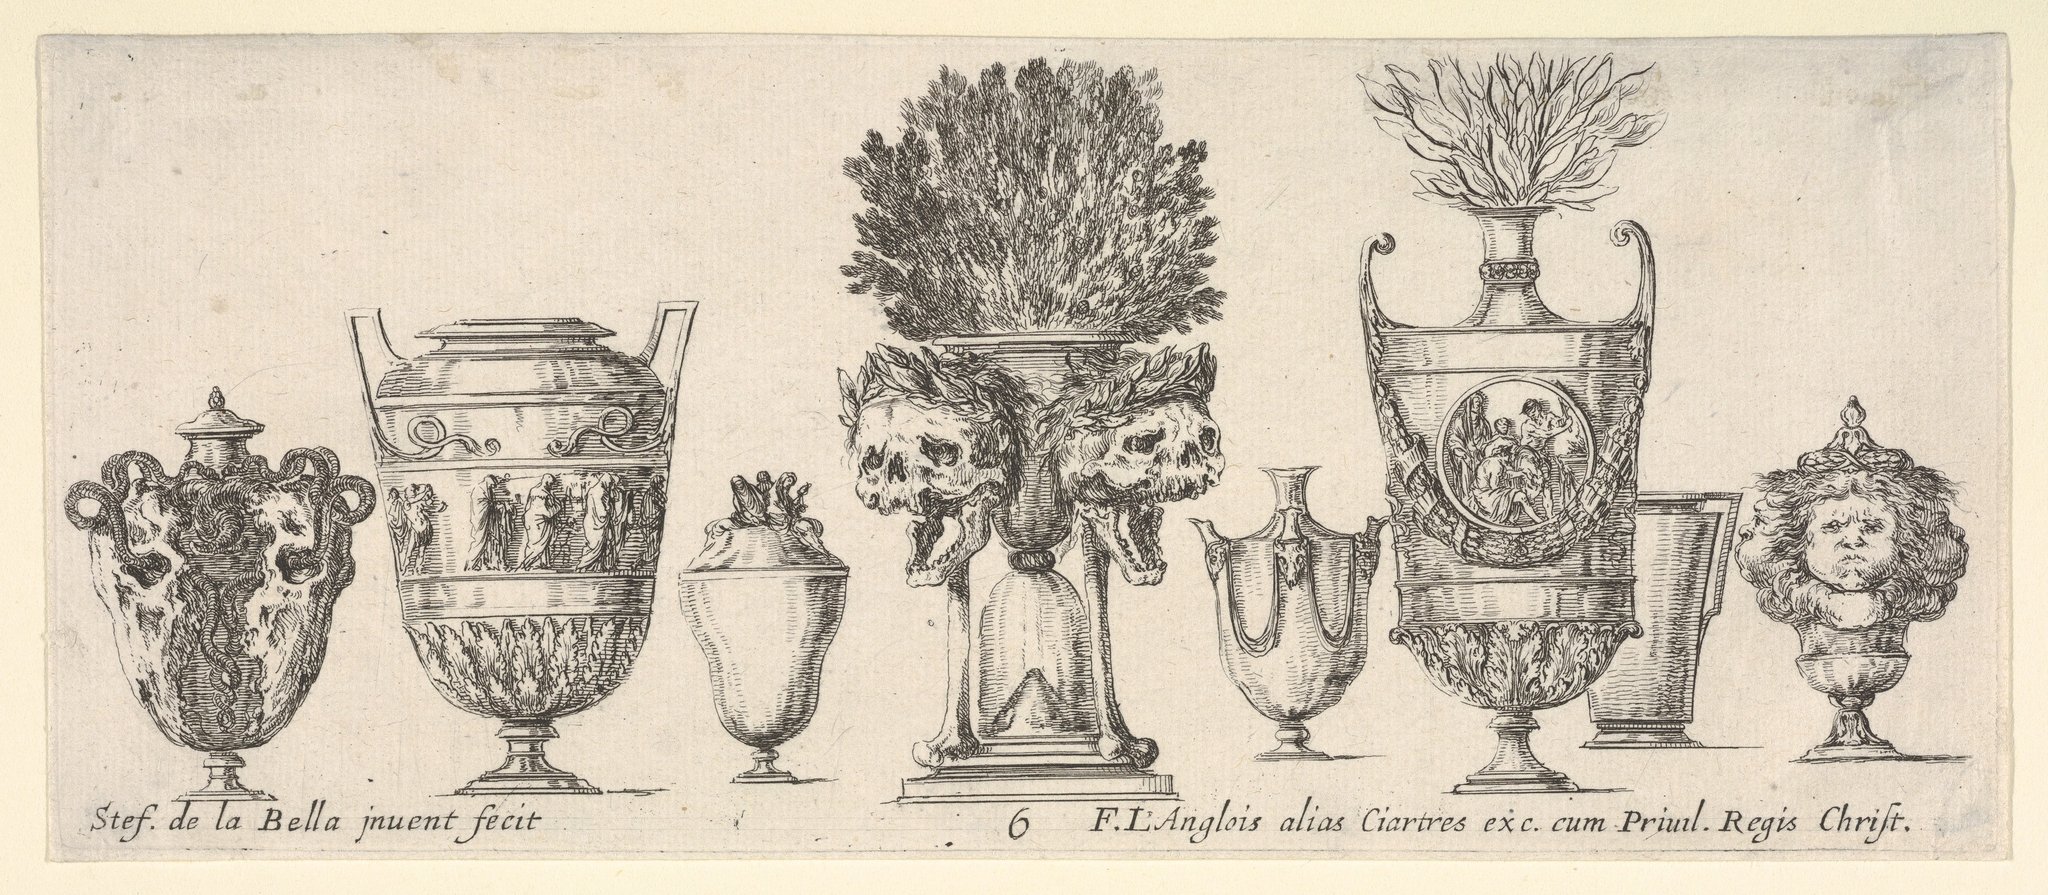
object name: print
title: Eight vases, a clepsydra in center decorated with two skulls with laurel wreaths, plate 6 from "Collection of Various Vases" (Raccolta di Vasi Diversi)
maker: stefano della bella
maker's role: artist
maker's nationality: italian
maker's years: 1610-1664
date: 1650-1656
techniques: etching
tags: skulls,heads,wreaths,vases